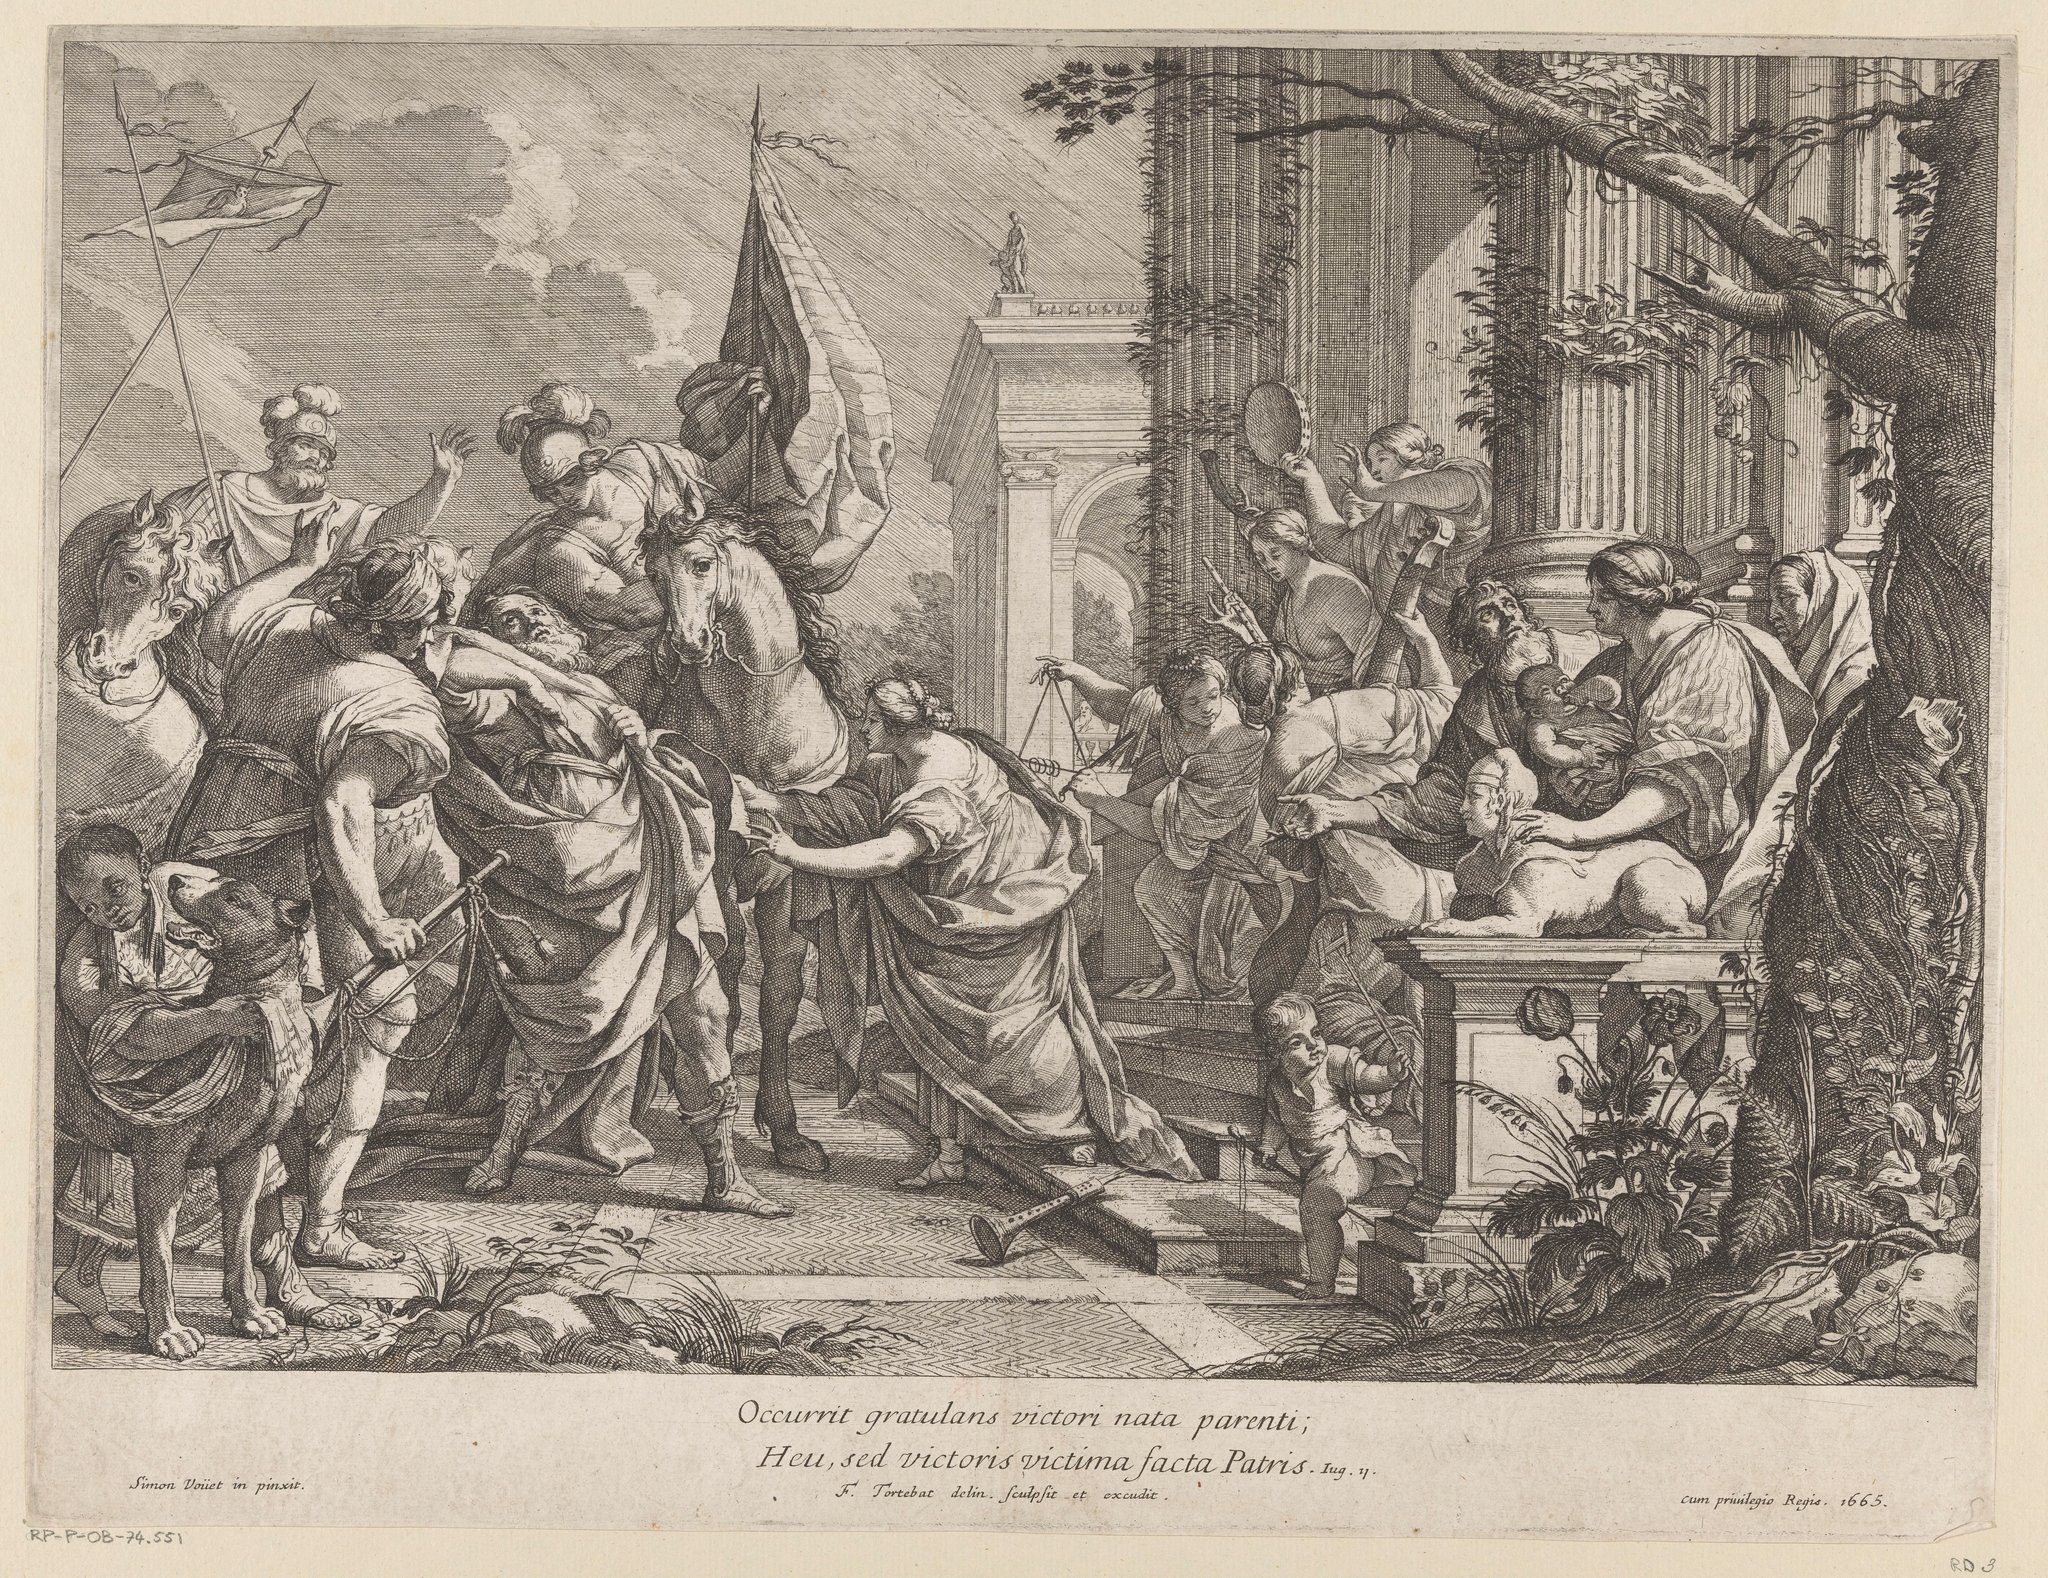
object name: print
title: Jefta wordt door zijn dochter verwelkomd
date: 1665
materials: paper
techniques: etching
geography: paris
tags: jephthah's daughter dances with tambourines to meet her father on his return from the battle; jephthah rends his clothes in despair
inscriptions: collector's mark: Lugt 240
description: Jefta komt thuis na zijn overwinning op de Ammonieten waar zijn dochter hem feestelijk onthaalt.